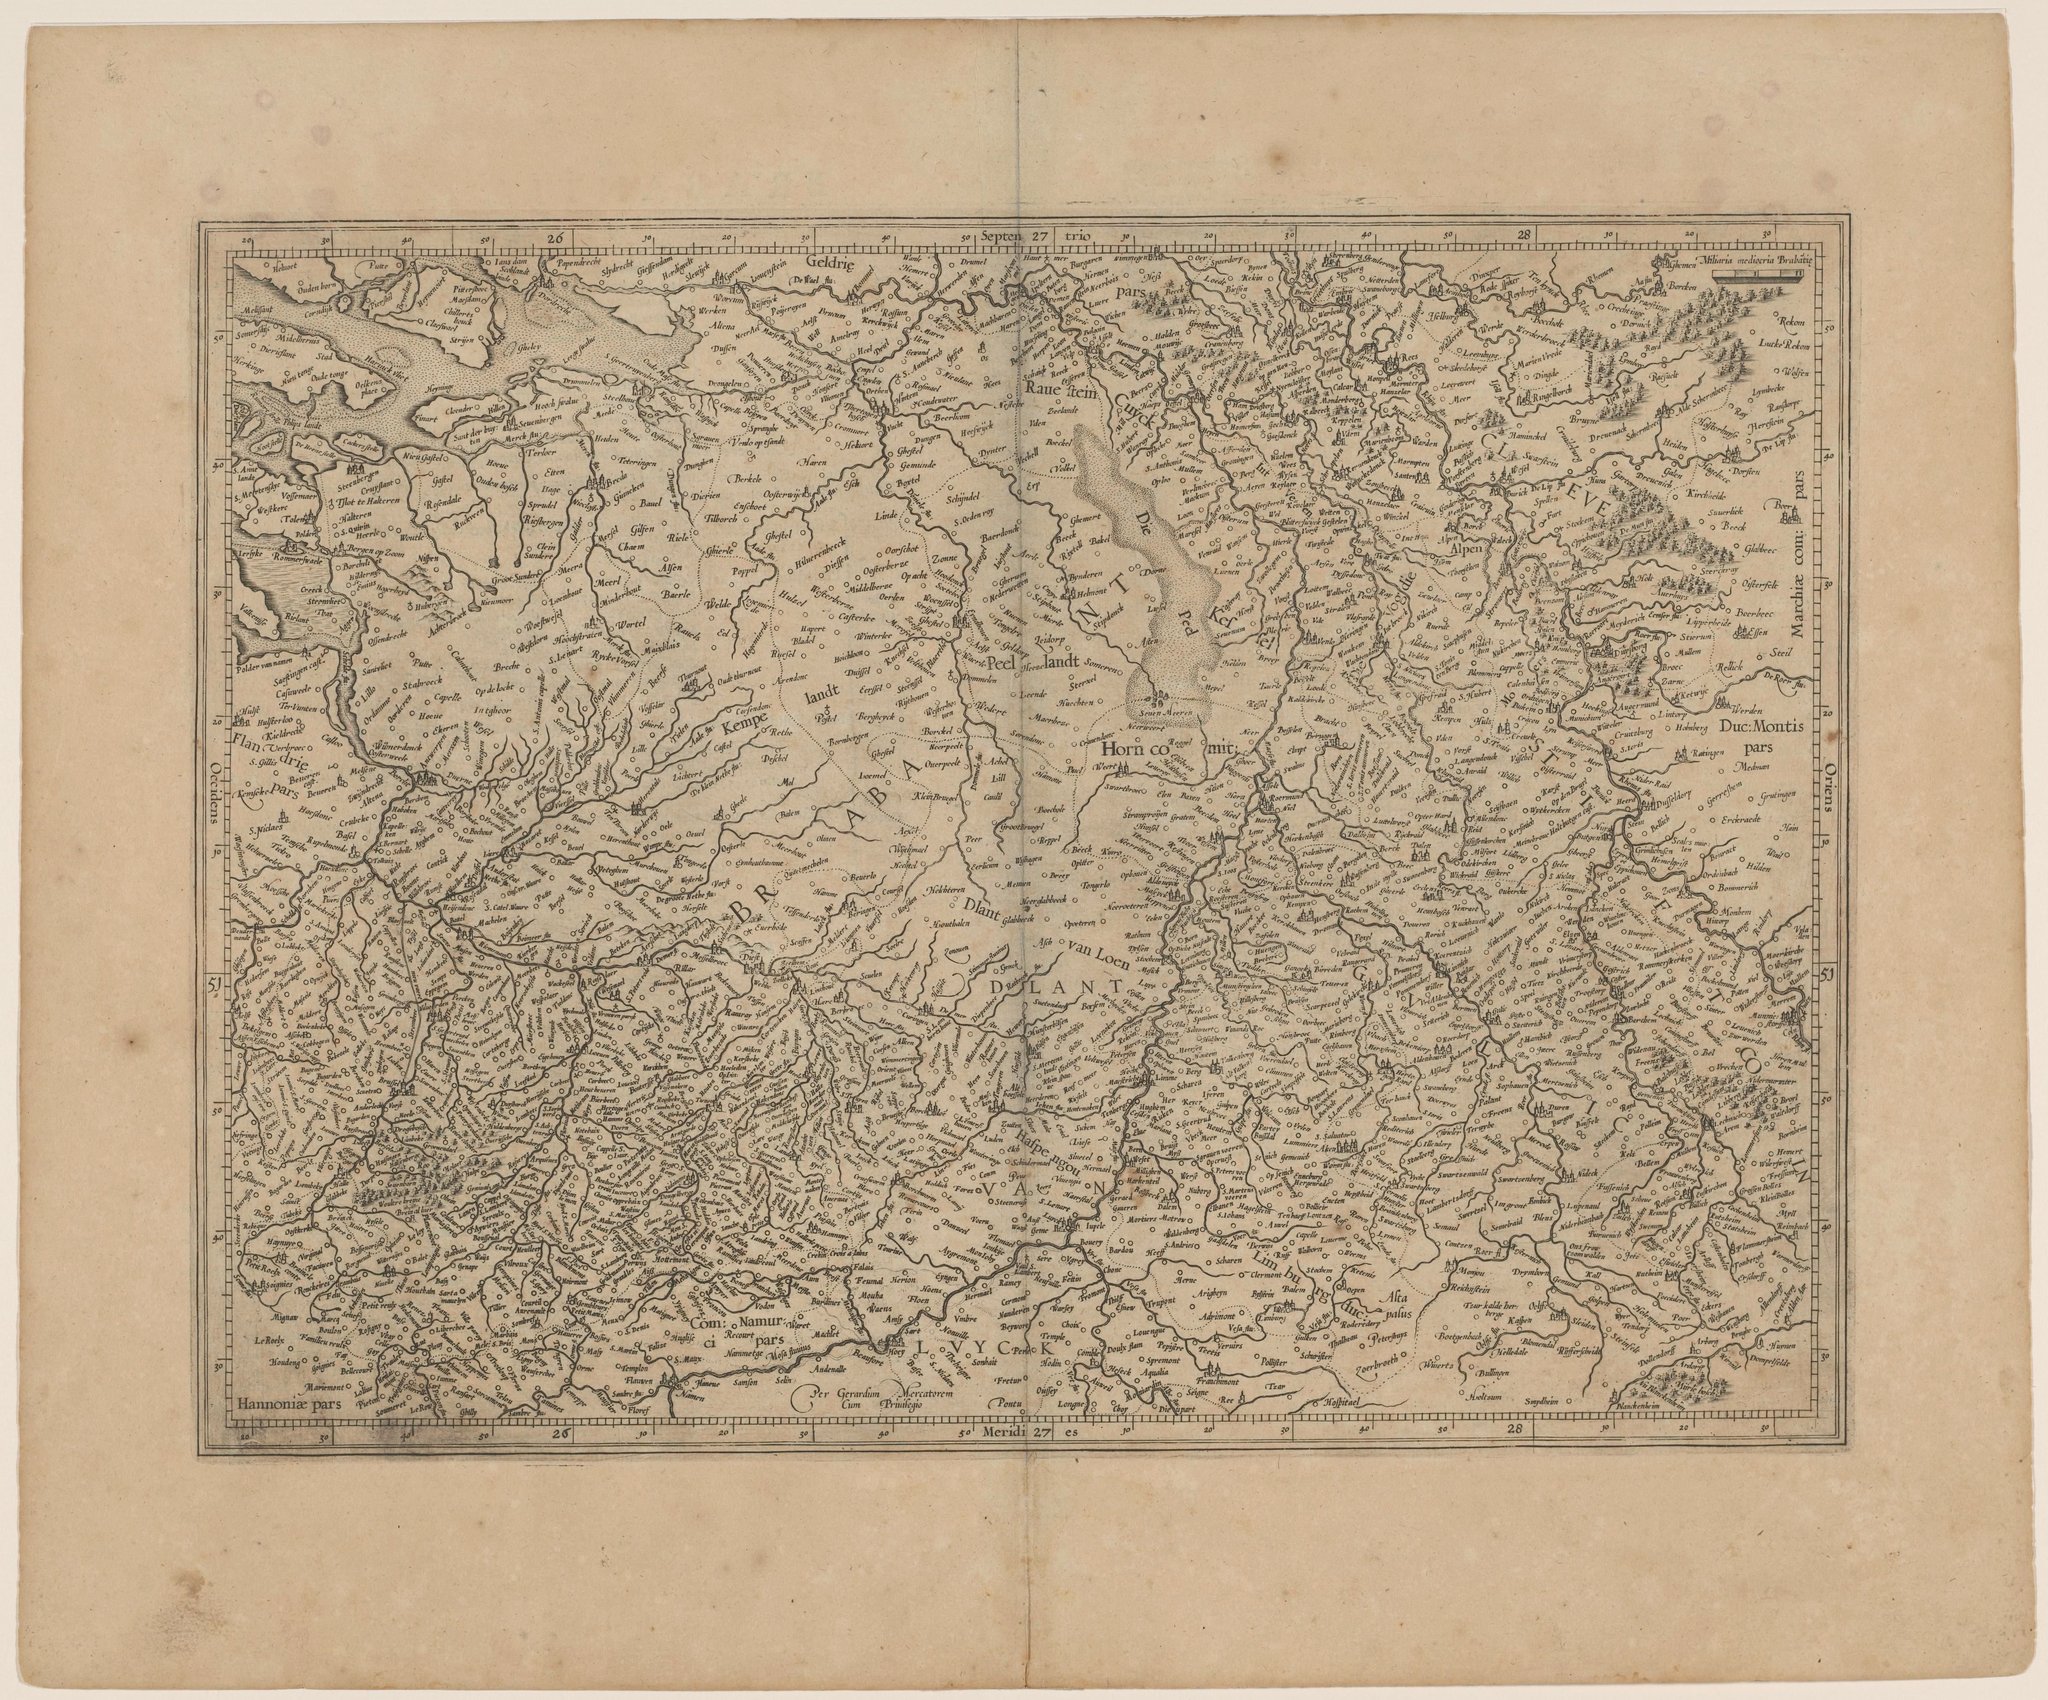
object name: map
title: Brabantia, Gulick et Cleve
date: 1611-1612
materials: paper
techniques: engraving, letterpress printing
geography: duisburg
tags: maps of separate countries or regions, brabant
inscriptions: collector's mark: Lugt 2228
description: Kaart van het hertogdom Brabant, Gulik en Kleef. Zonder titel in kaartbeeld. De kaart is voorzien van een gradenverdeling langs de randen. Met Latijnse tekst op verso.